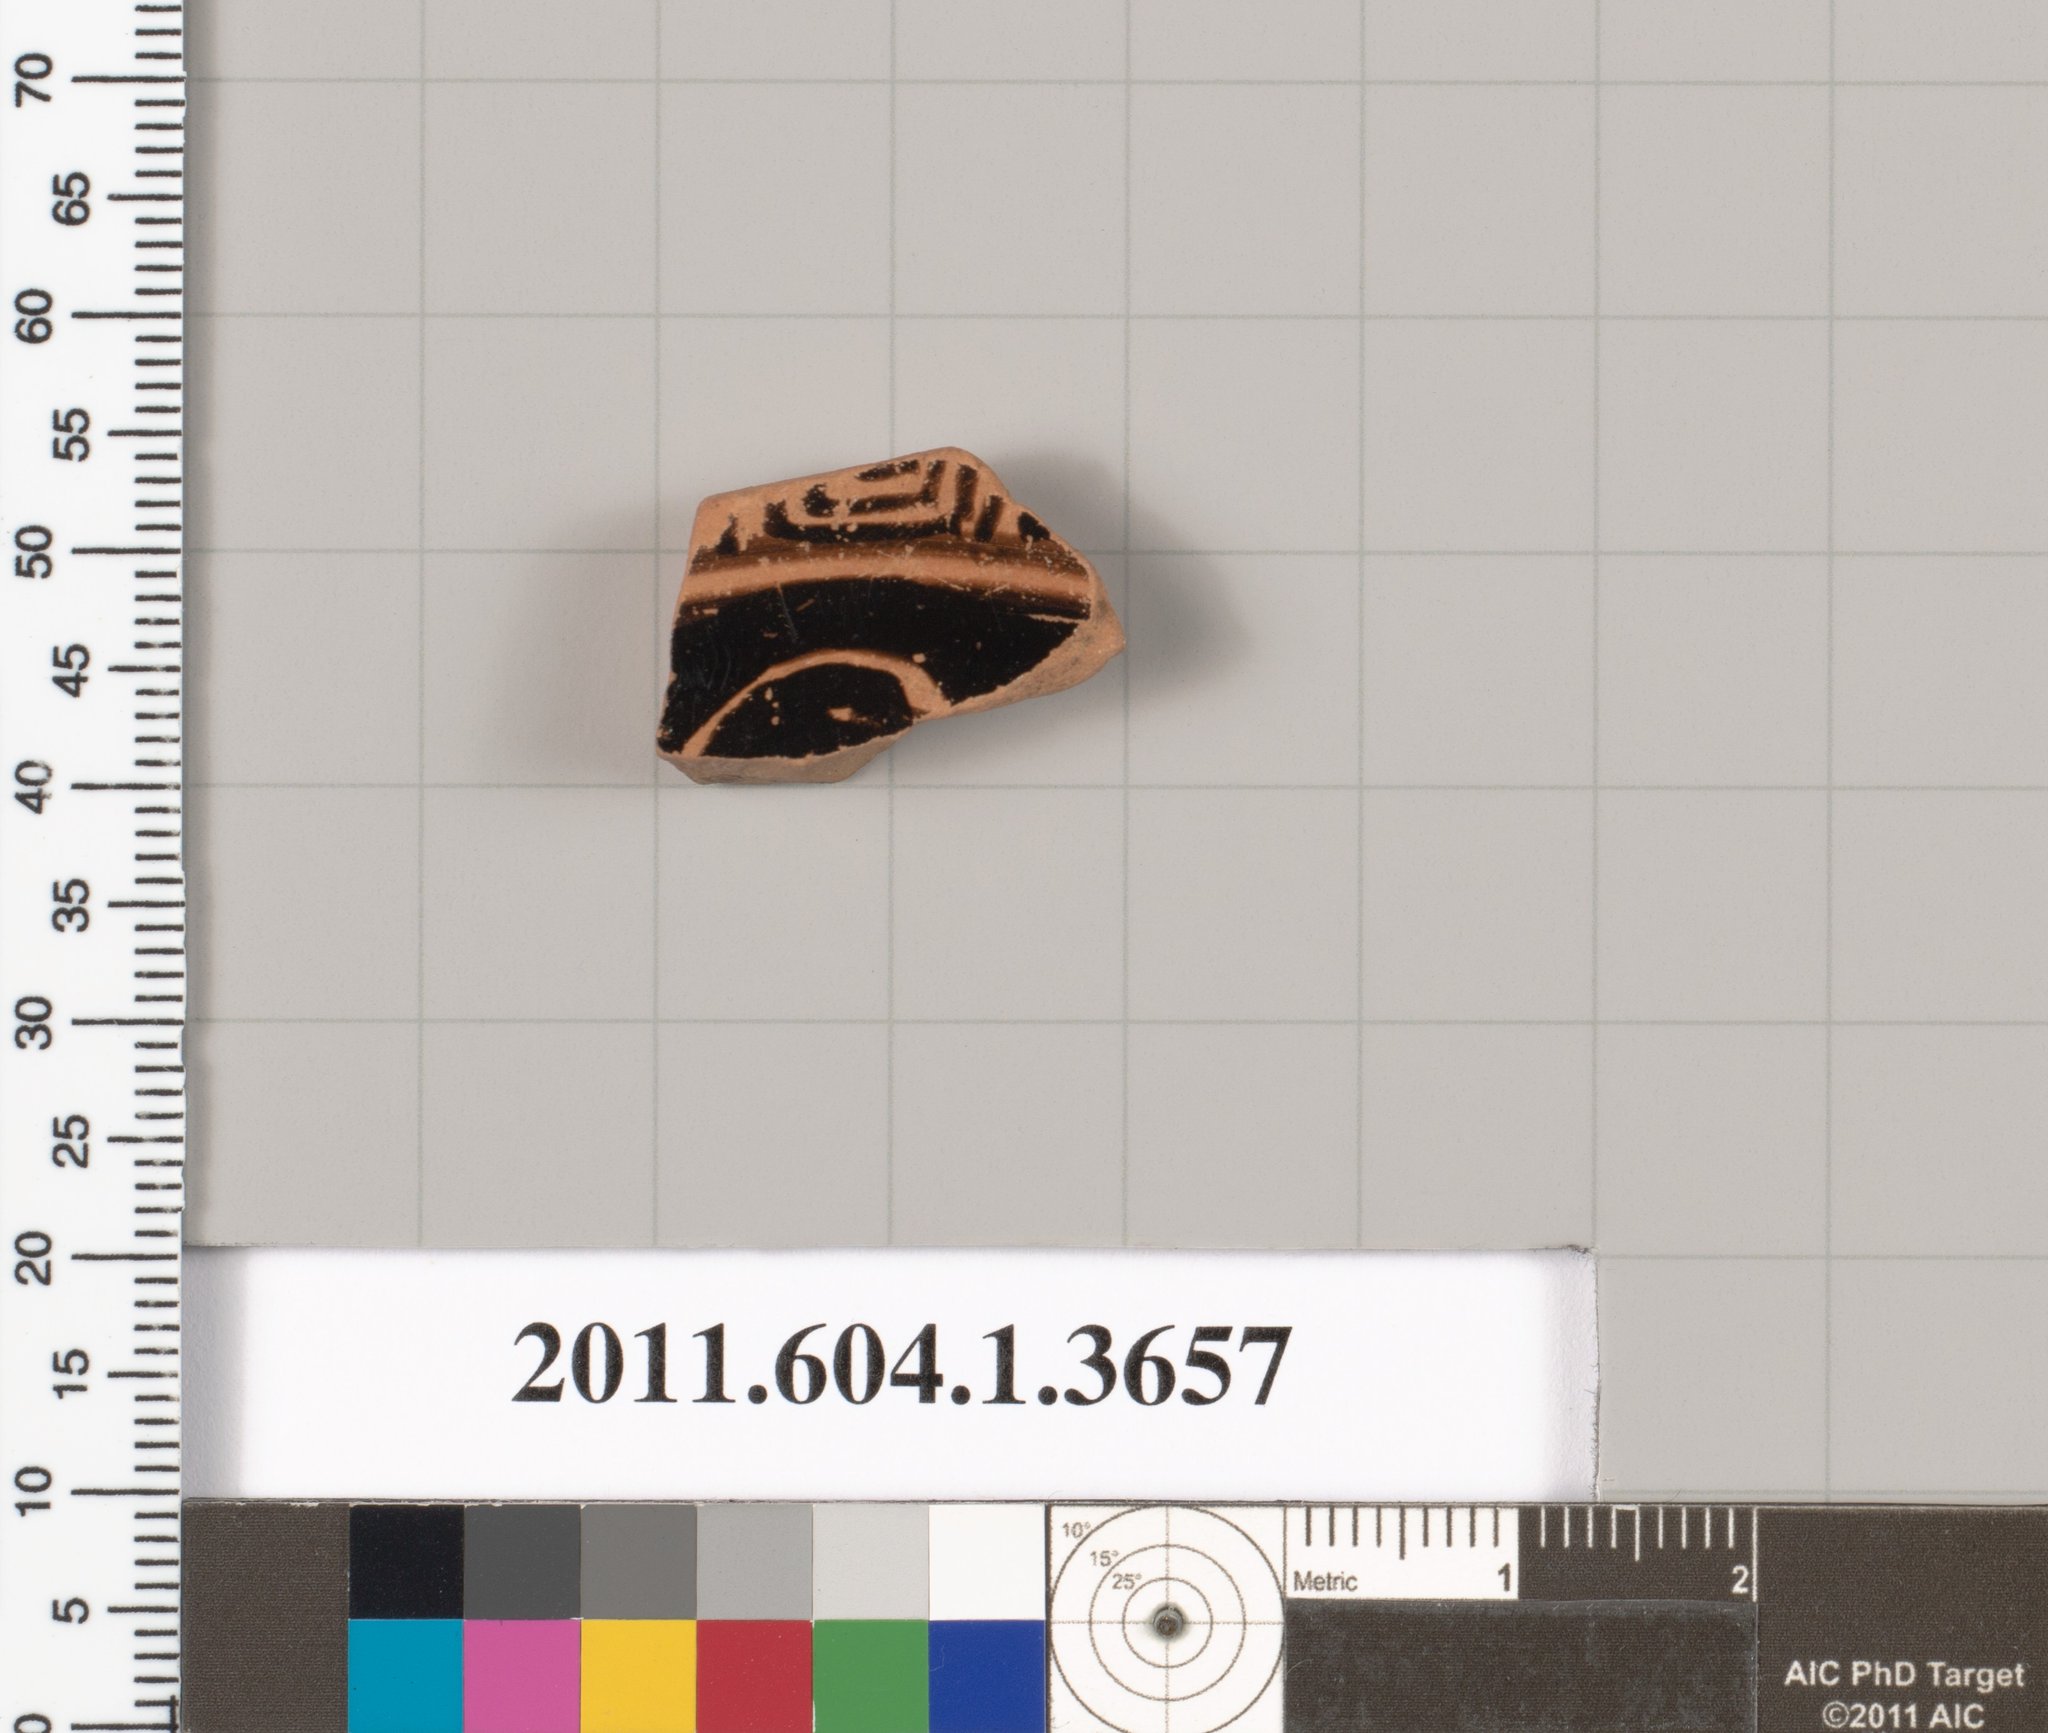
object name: kylix fragment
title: Terracotta fragment of a kylix (drinking cup)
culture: greek, attic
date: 500-470 BCE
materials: terracotta